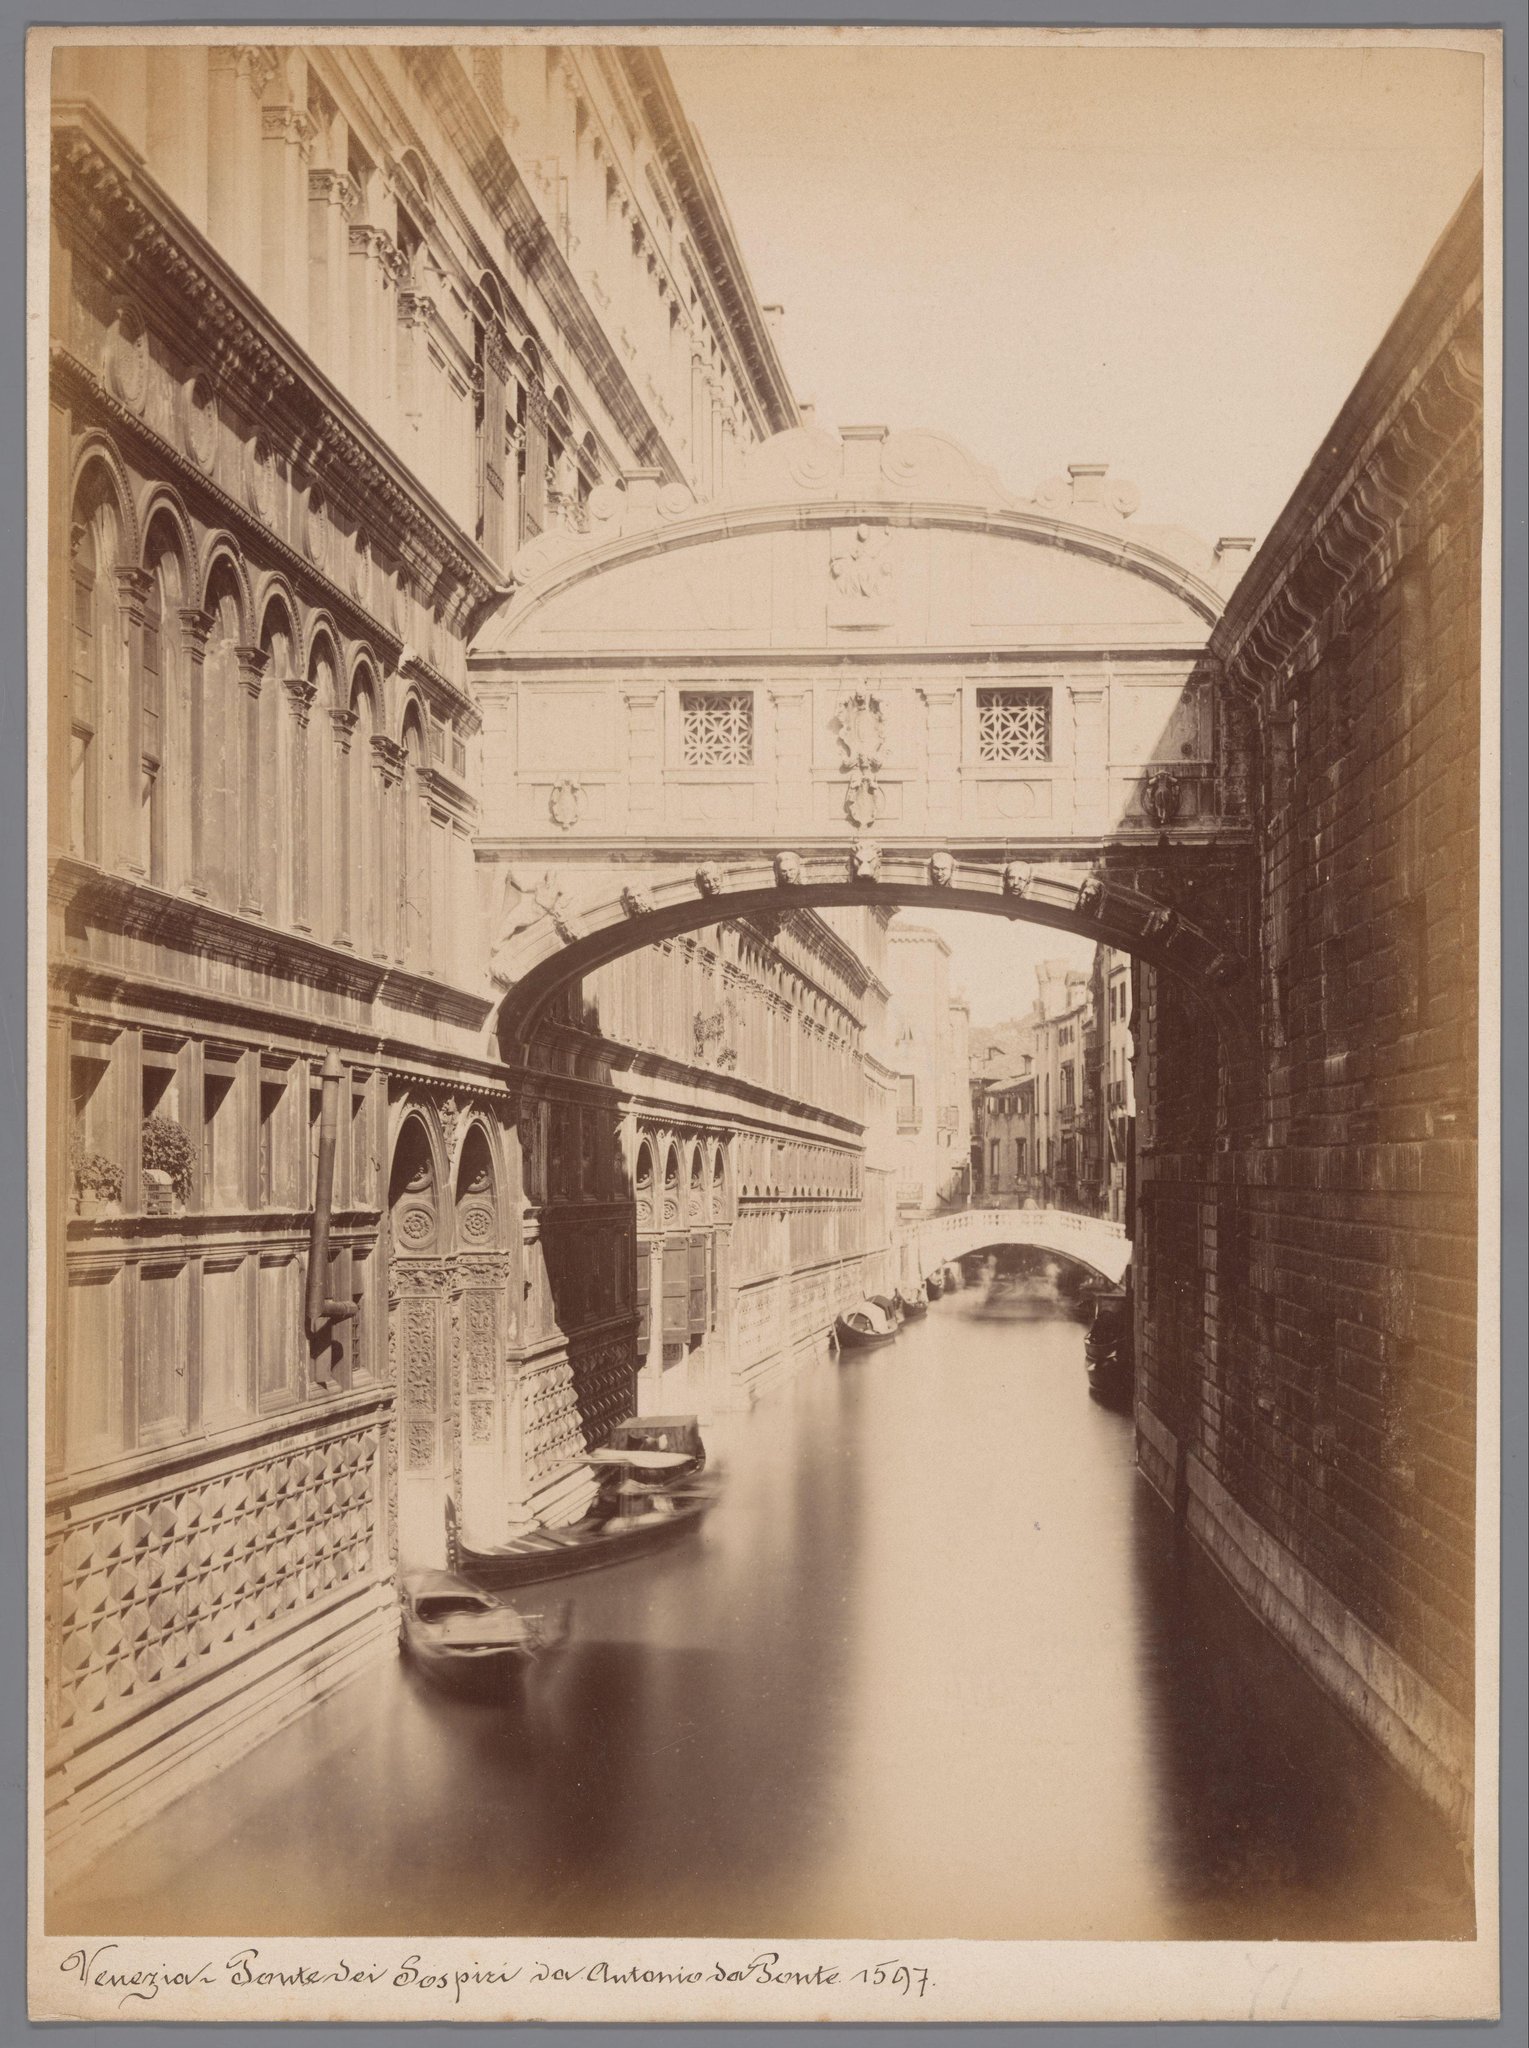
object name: photograph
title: Venezia - Ponte dei Sospiri da Antonio da Ponte 1597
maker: Anonymous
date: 1851-1900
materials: cardboard, paper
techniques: albumen print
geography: venice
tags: bridge in city across river, canal, etc.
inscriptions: number: ‘71’